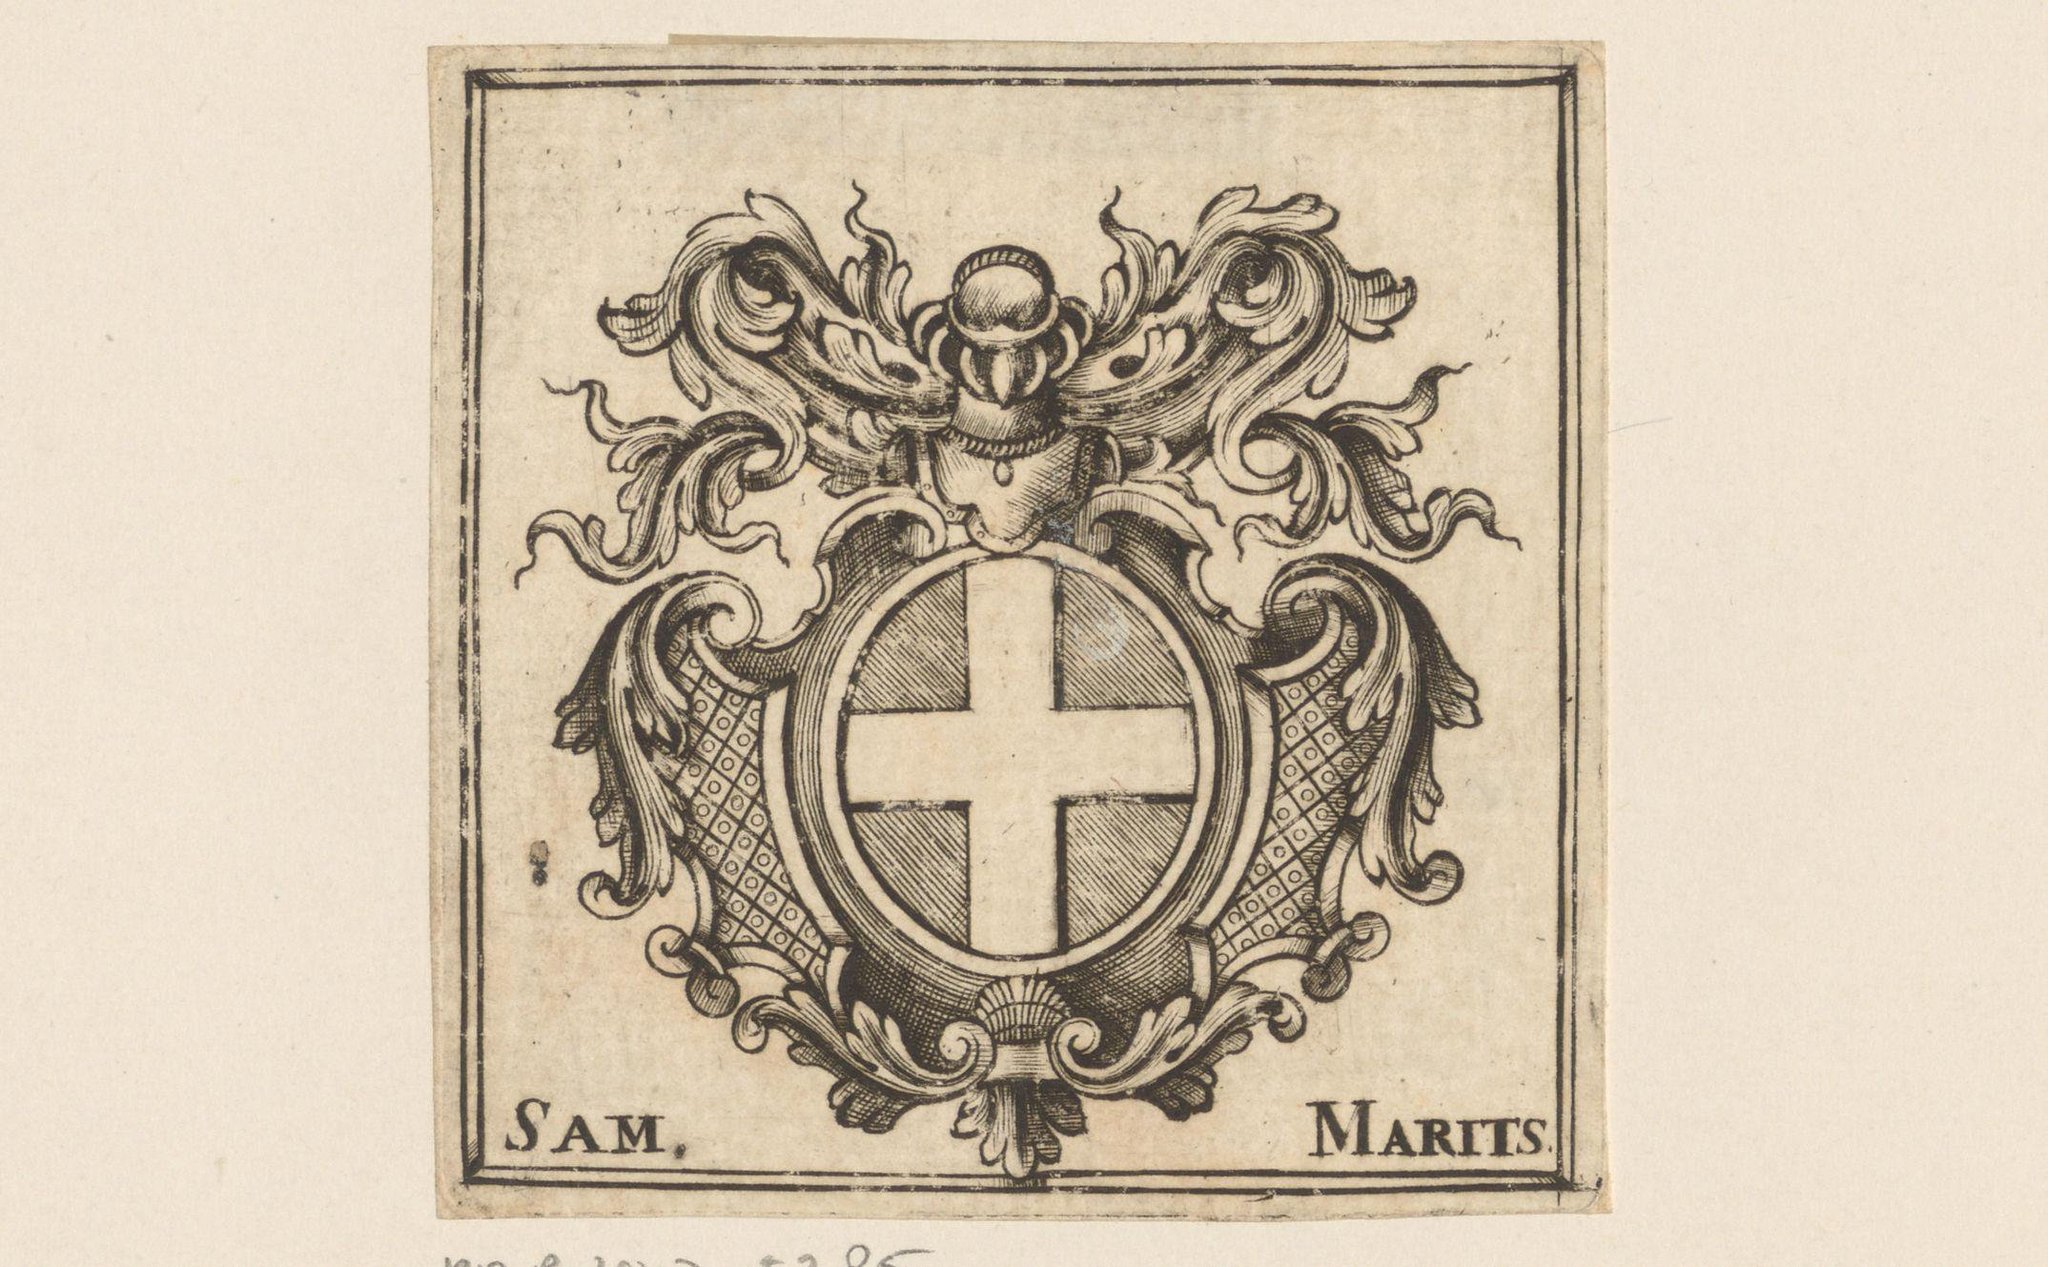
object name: bookplate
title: Ex libris van Sam. Marits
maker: Anonymous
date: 1630-1699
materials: paper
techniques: etching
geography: netherlands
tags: armorial bearing, heraldry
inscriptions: inscription: ‘De Hollandsche familie / Maritz / voert: van sabel met een kruis van zilver’